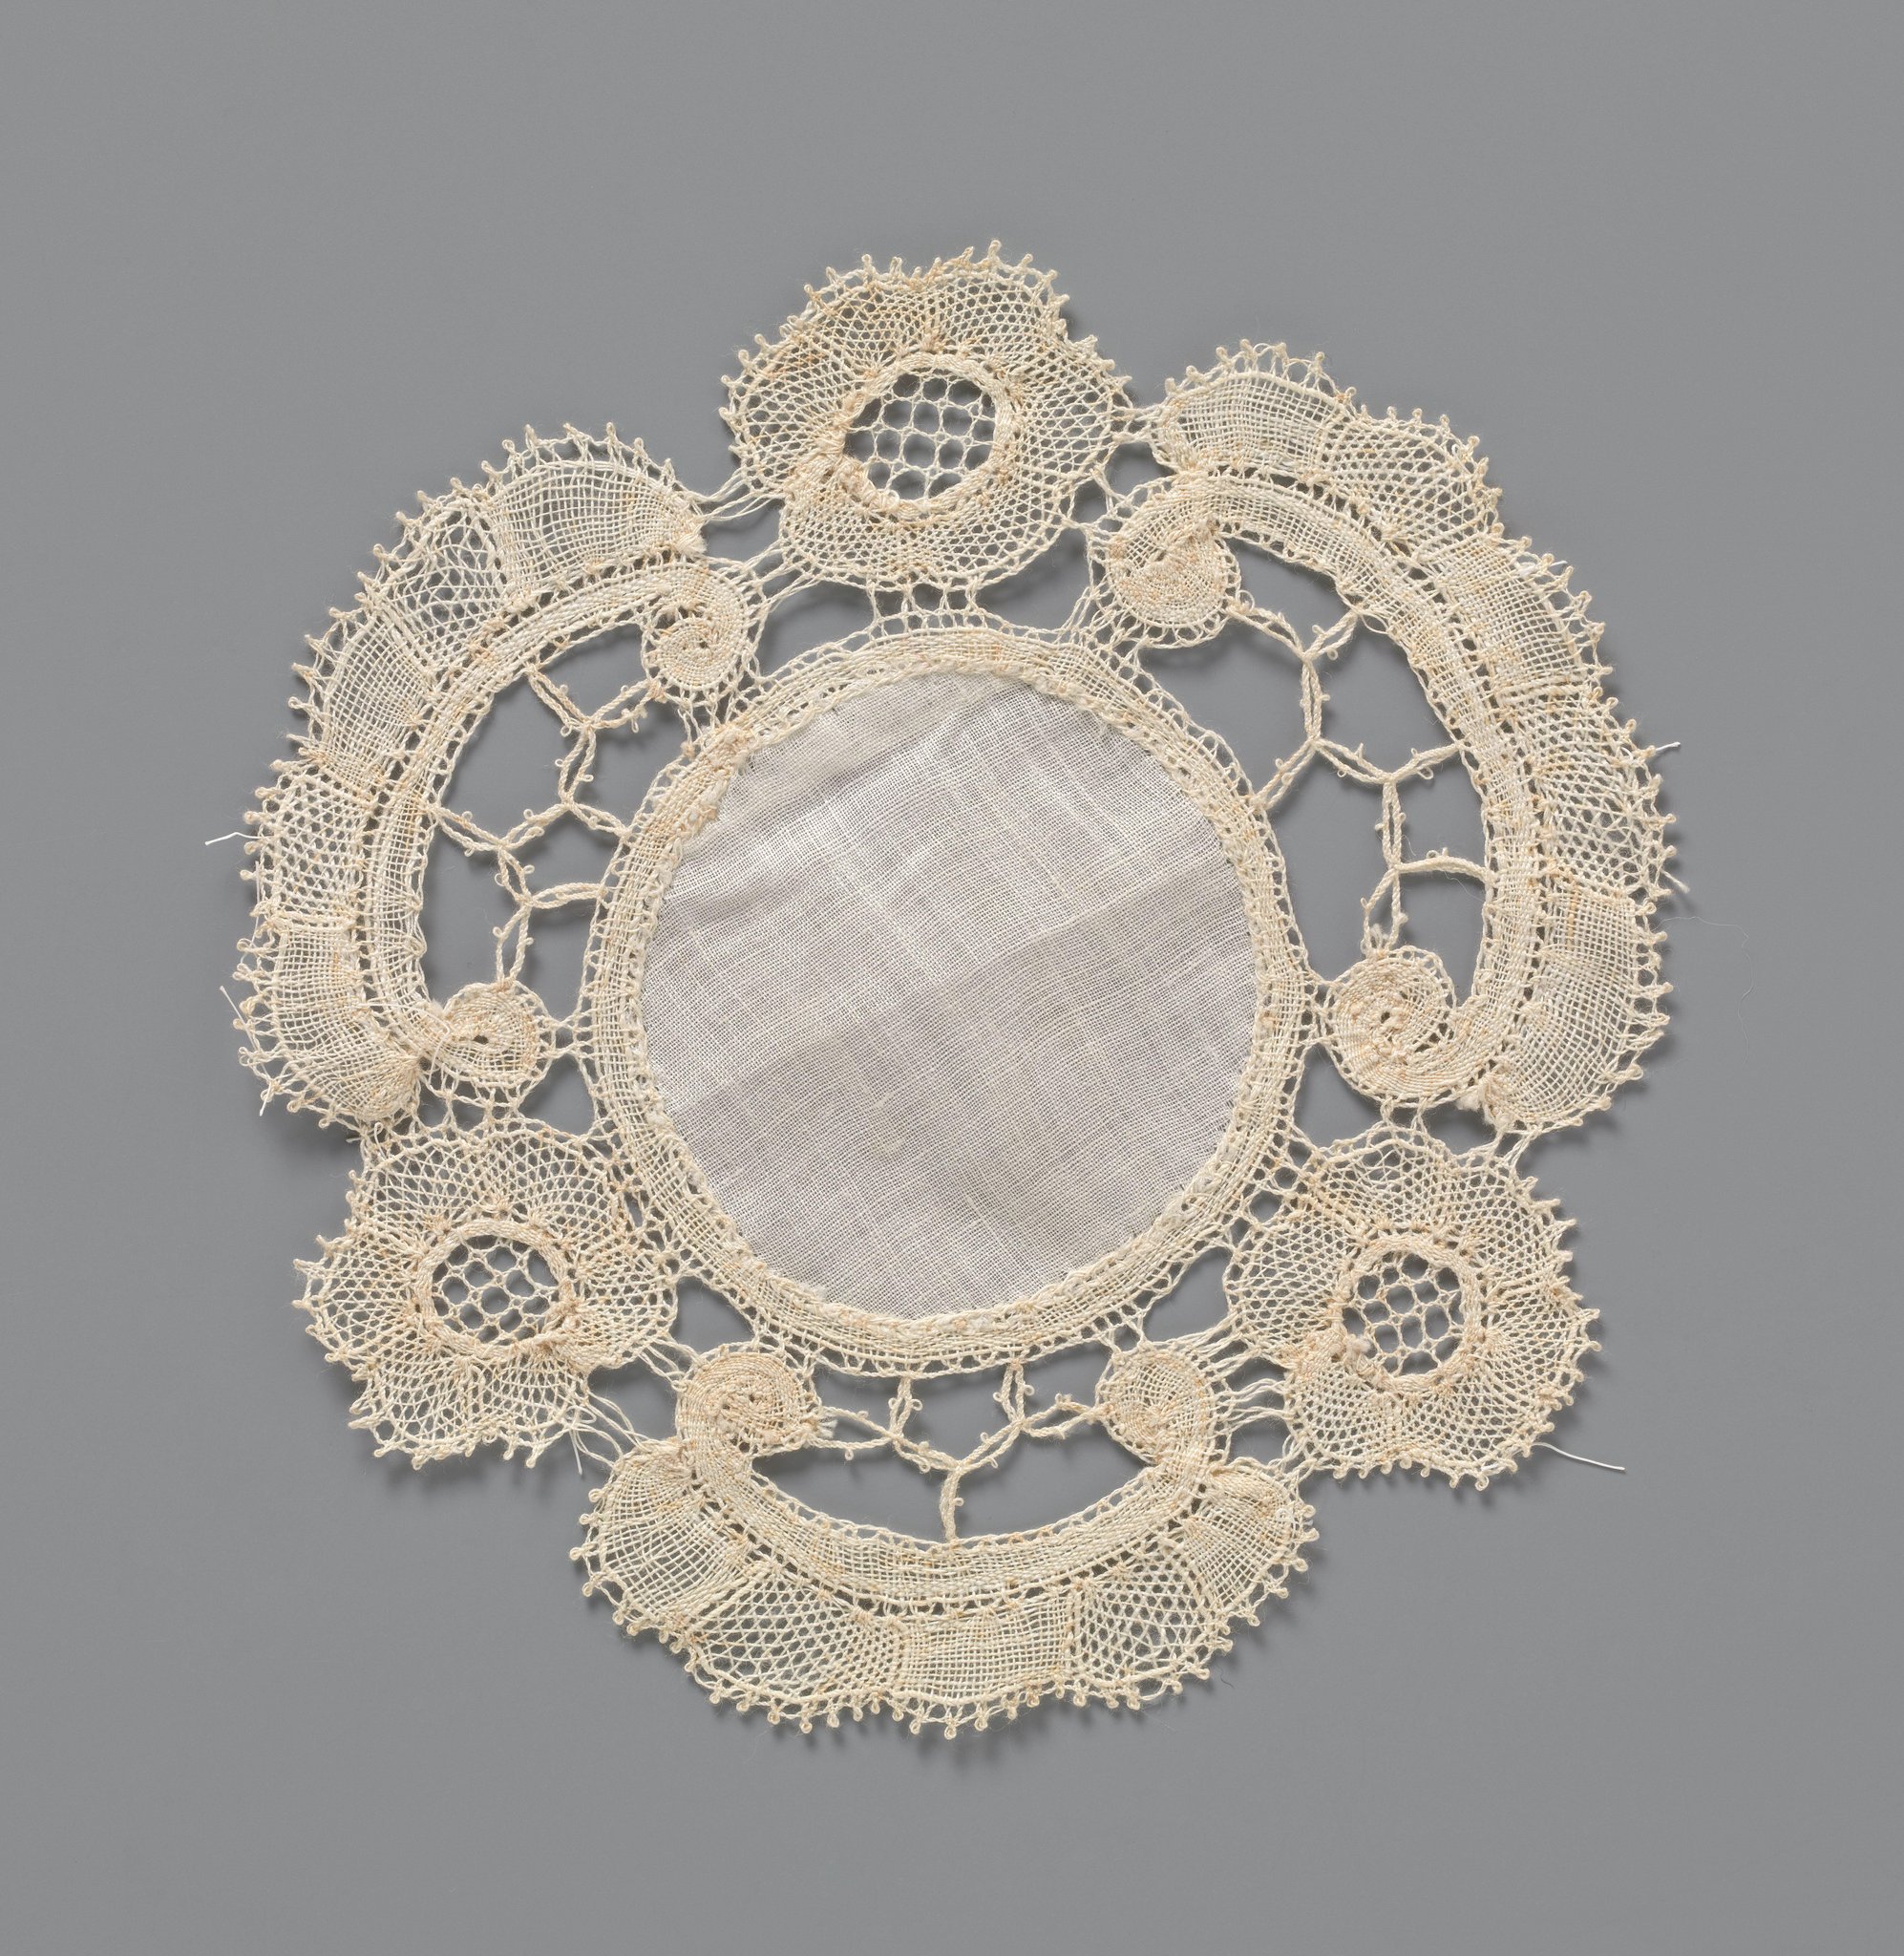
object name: kleed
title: Kleed of doily van kloskant met c-voluut en rozetbloem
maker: Anonymous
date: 1900-1924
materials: linen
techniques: lace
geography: bruges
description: Kleed of doily van naturelkleurig kloskant: Brugs bloemwerk. Rond model met rond middenstuk van batist. Het zich herhalende patroon bestaat afwisselend uit een c-voluut en rozetbloem. De motieven zijn geklost in netslag en linnenslag met opengewerkte randjes. De motieven zijn geaccentueerd door contourdraden. In de bloemharten is een siergrondje toegepast, een gesloten speldslag-grond. Tussen de motieven zijn enkele verbindingen gemaakt met dubbele vlechtjes met picots, die driepuntige sterren vormen. De schulpenrand komt voort uit het patroon en is rondom afgewerkt met picots.